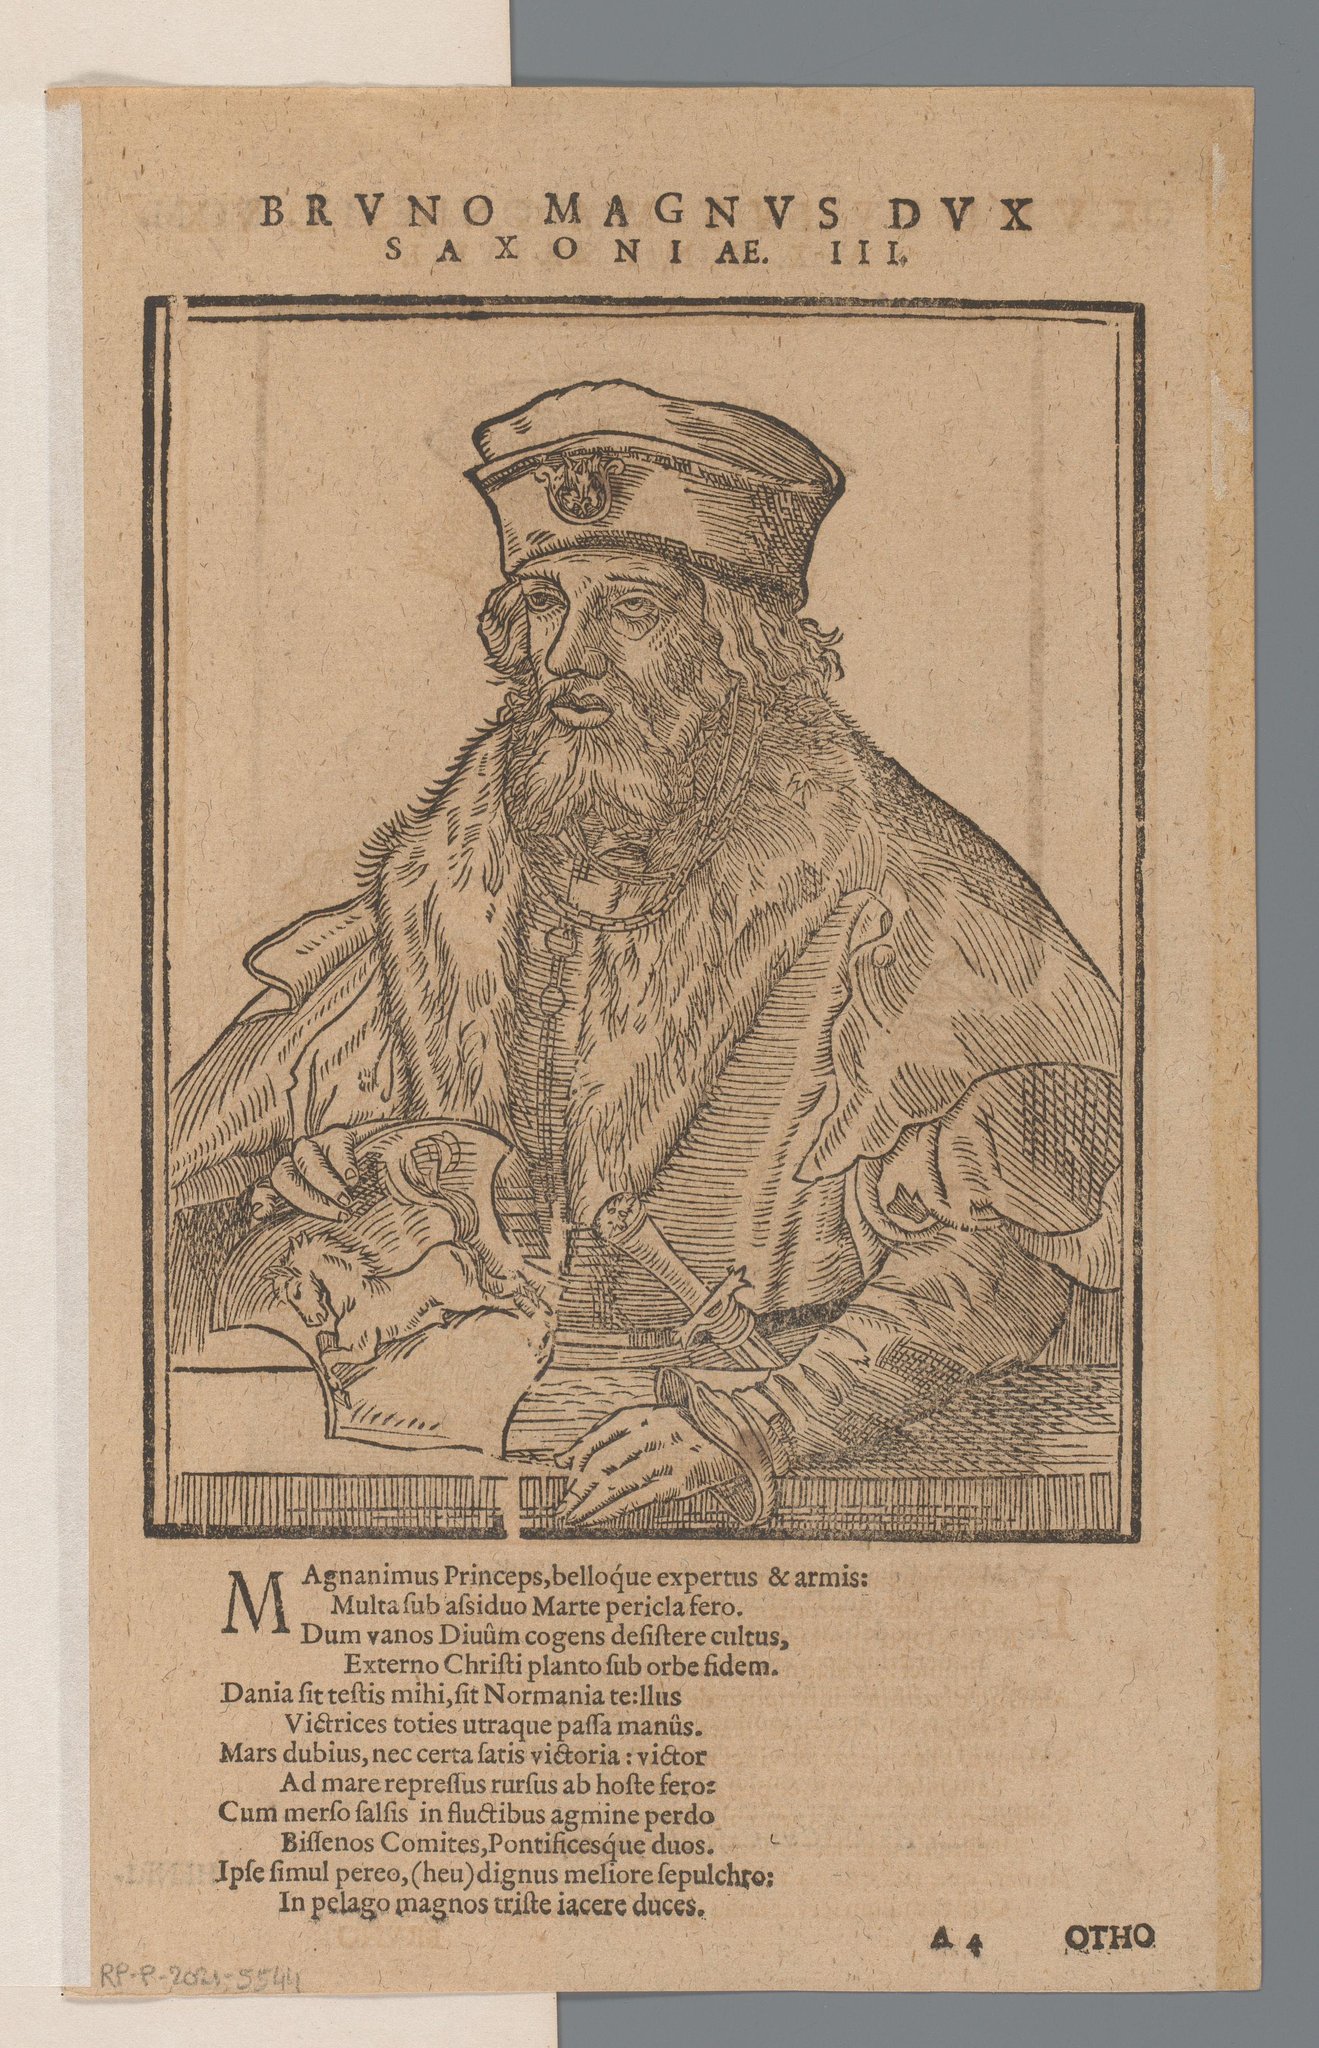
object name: print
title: Portret van Brun van Saksen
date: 1597-1610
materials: paper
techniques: letterpress printing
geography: leipzig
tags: historical persons, armorial bearing, heraldry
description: Prent uit: Reusner, Elias. Genealogiae regum electorum ducum (...). Leipzig: Henning Grosse I, 1610. Of een eerdere publicatie (1597).